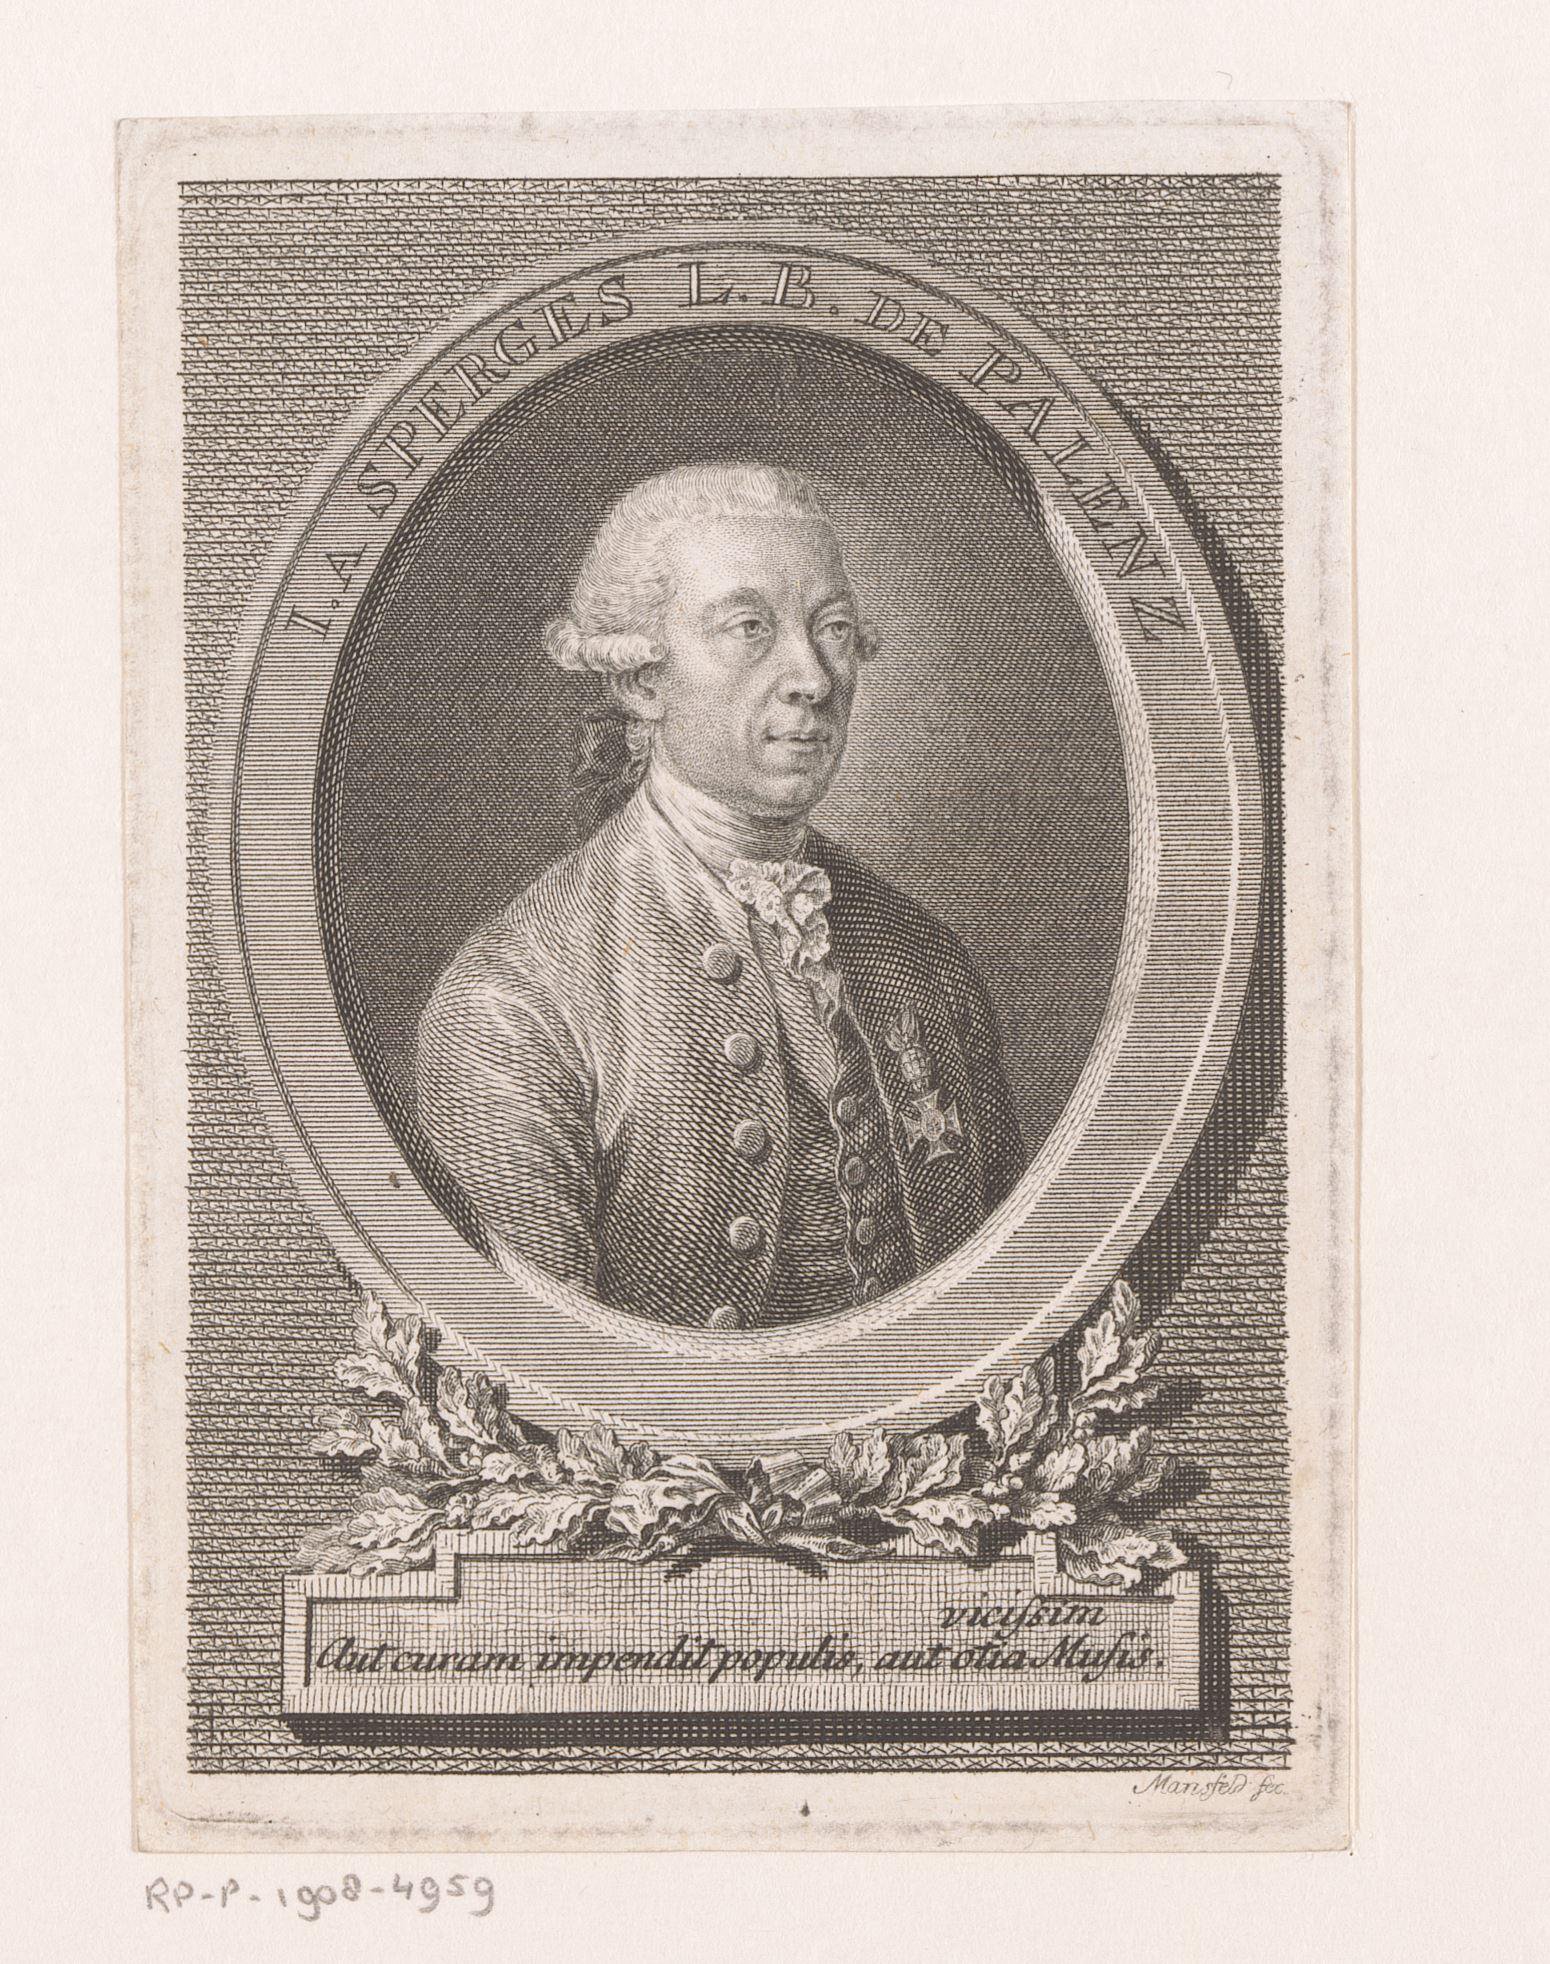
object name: print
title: Portret van Joseph von Sperges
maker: johann ernst mansfeld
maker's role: print maker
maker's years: 1739-1796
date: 1749-1796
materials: paper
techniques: engraving, etching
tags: historical persons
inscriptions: collector's mark: Lugt 2228